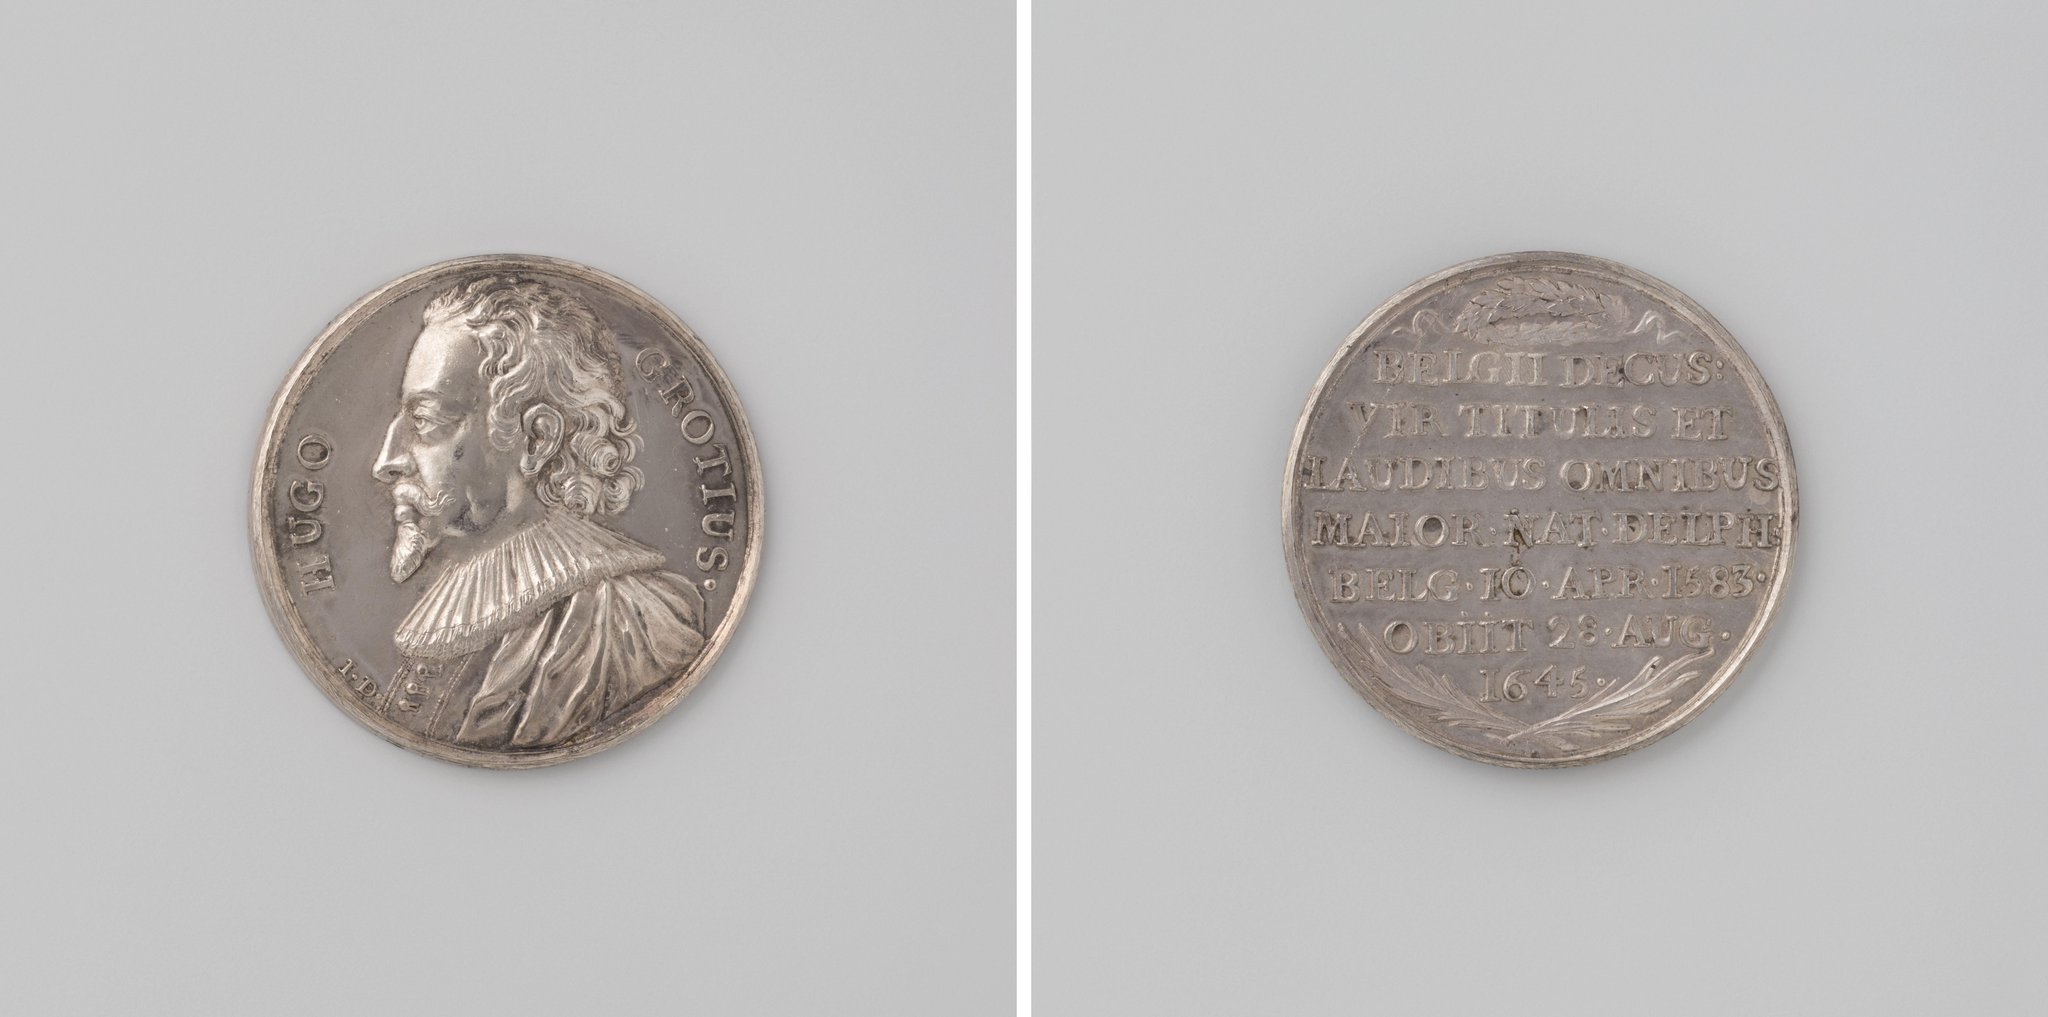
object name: history medal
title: Dood van Hugo de Groot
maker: jean dassier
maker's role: medailleur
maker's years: 1676-1763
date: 1725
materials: silver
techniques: striking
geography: geneva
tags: delft, hugo de groot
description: Zilveren penning. Voorzijde: borststuk man binnen omschrift. Keerzijde: opschrift onder lauwerkrans, boven palmtakken